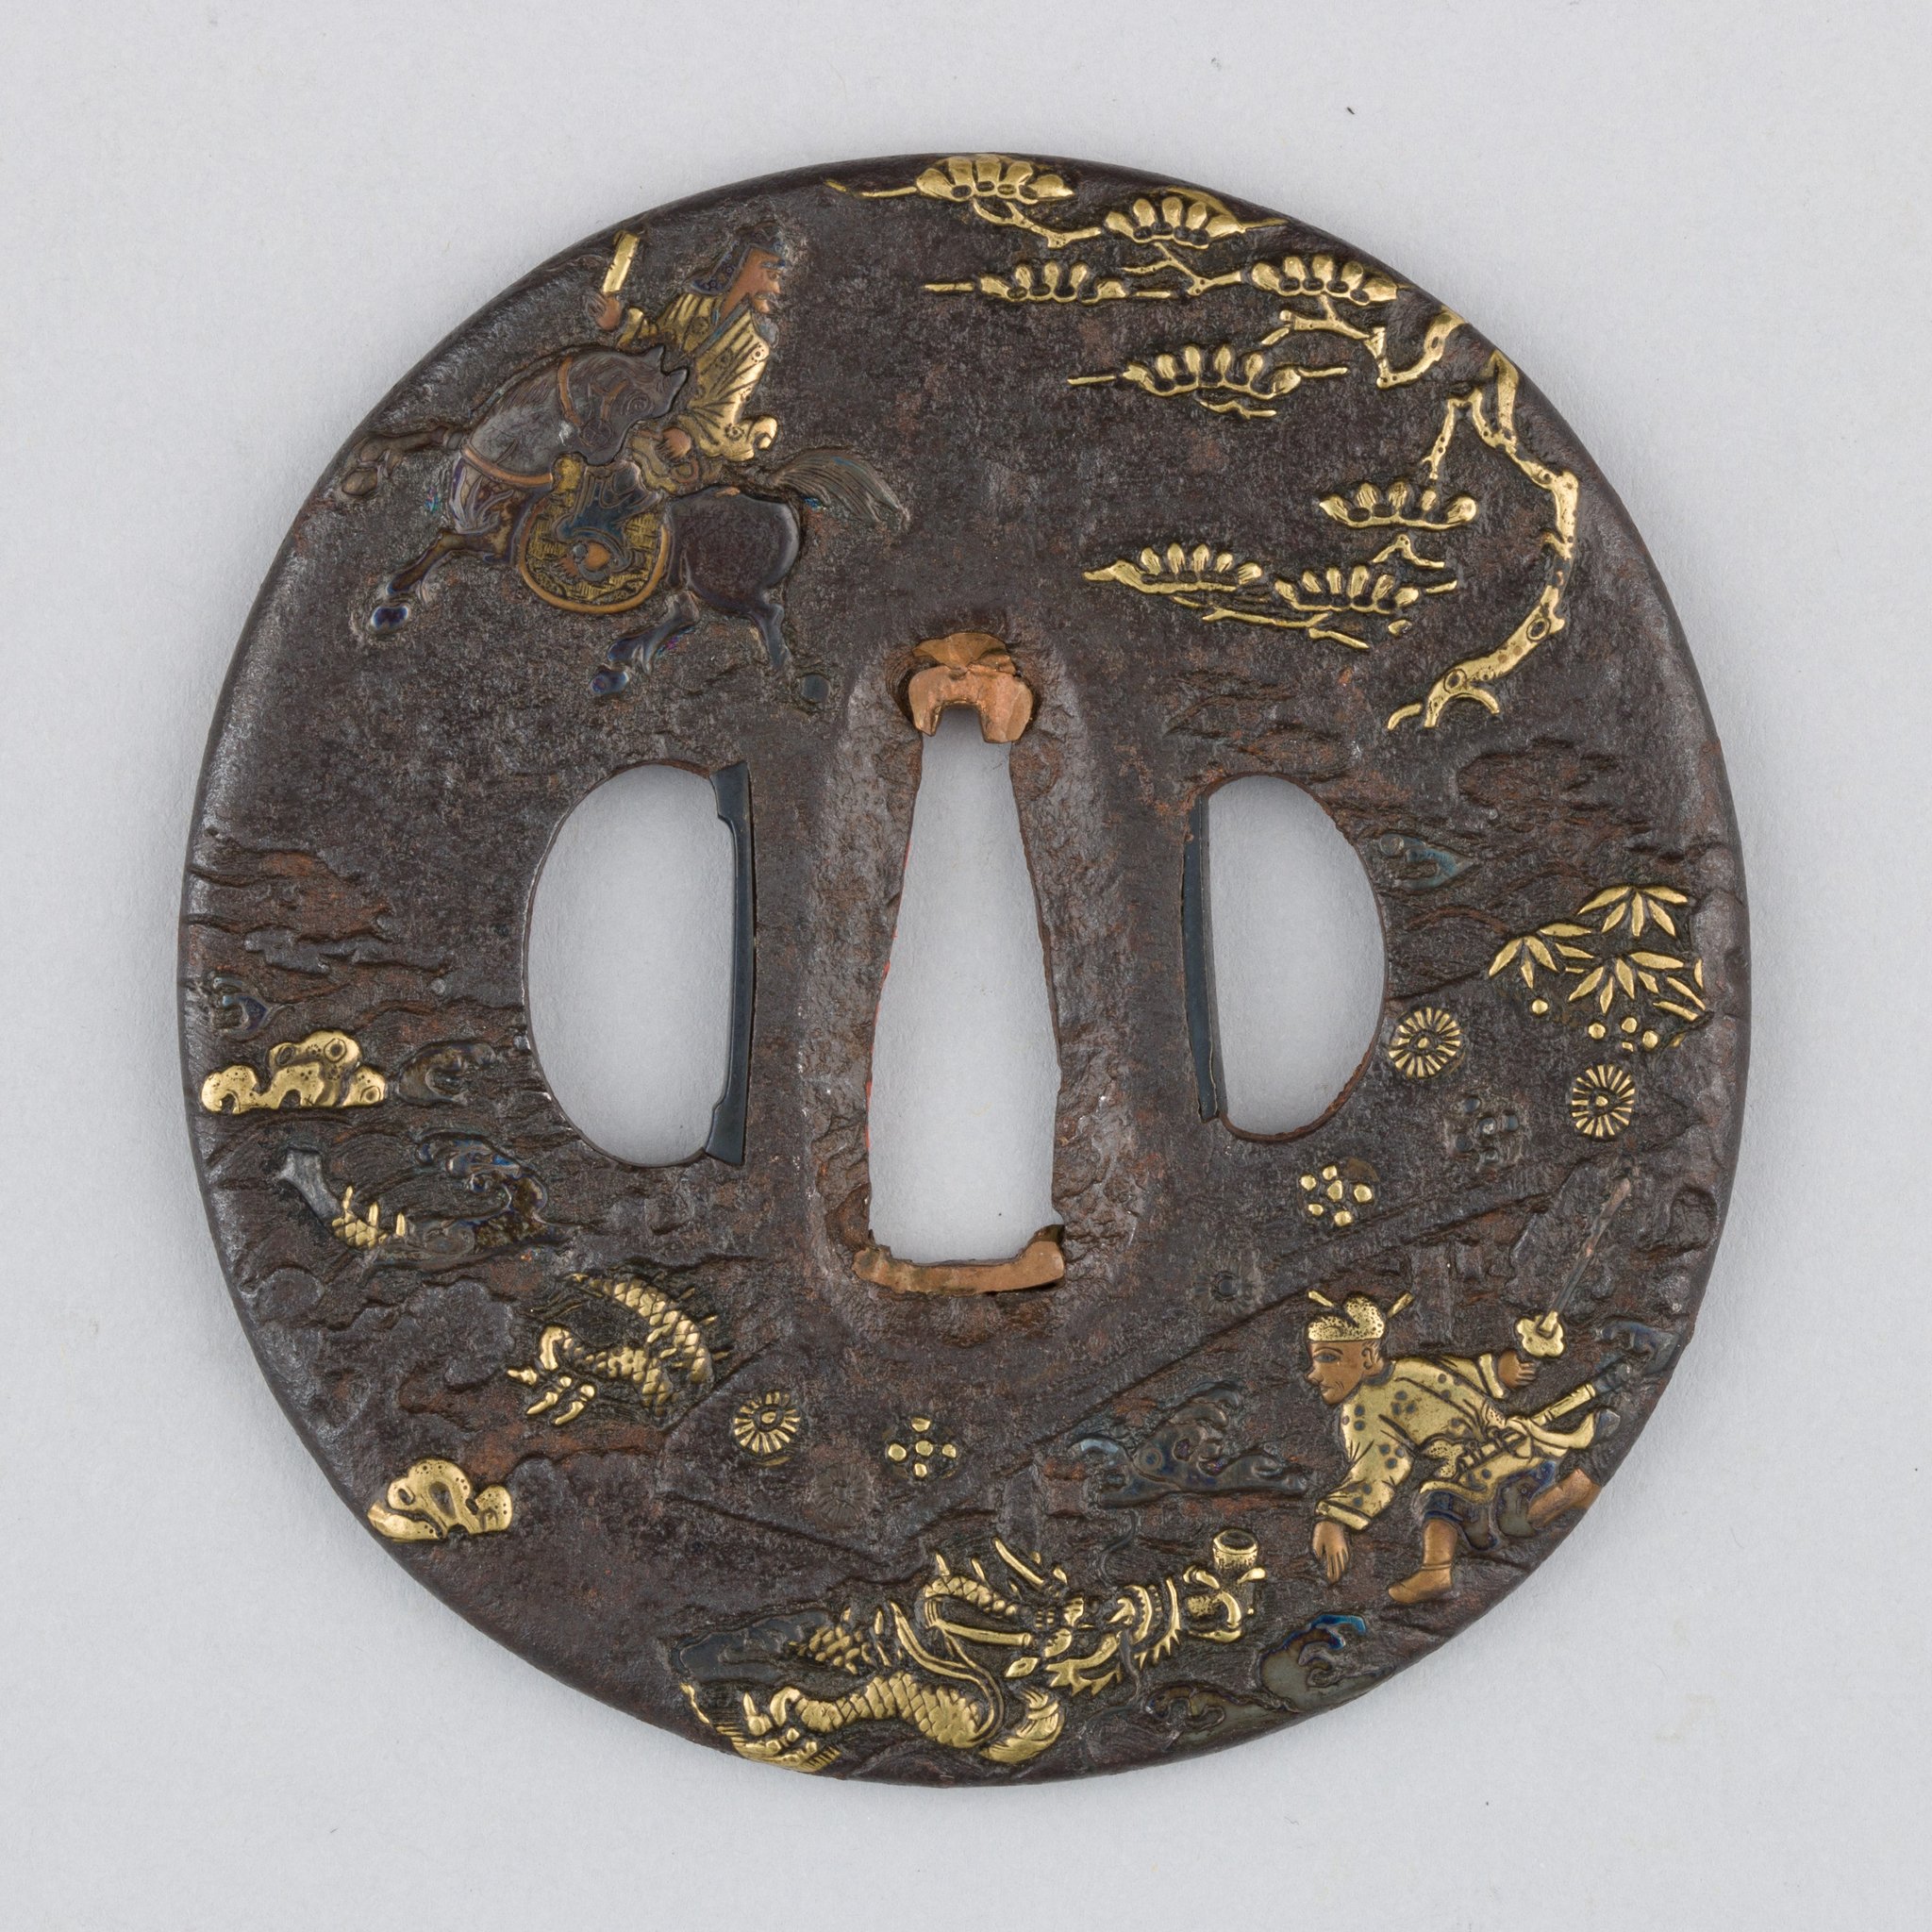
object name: sword guard tsuba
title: Sword Guard (Tsuba)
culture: japanese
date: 1567-1600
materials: brass, copper, iron, silver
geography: japan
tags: men,dragons,horses